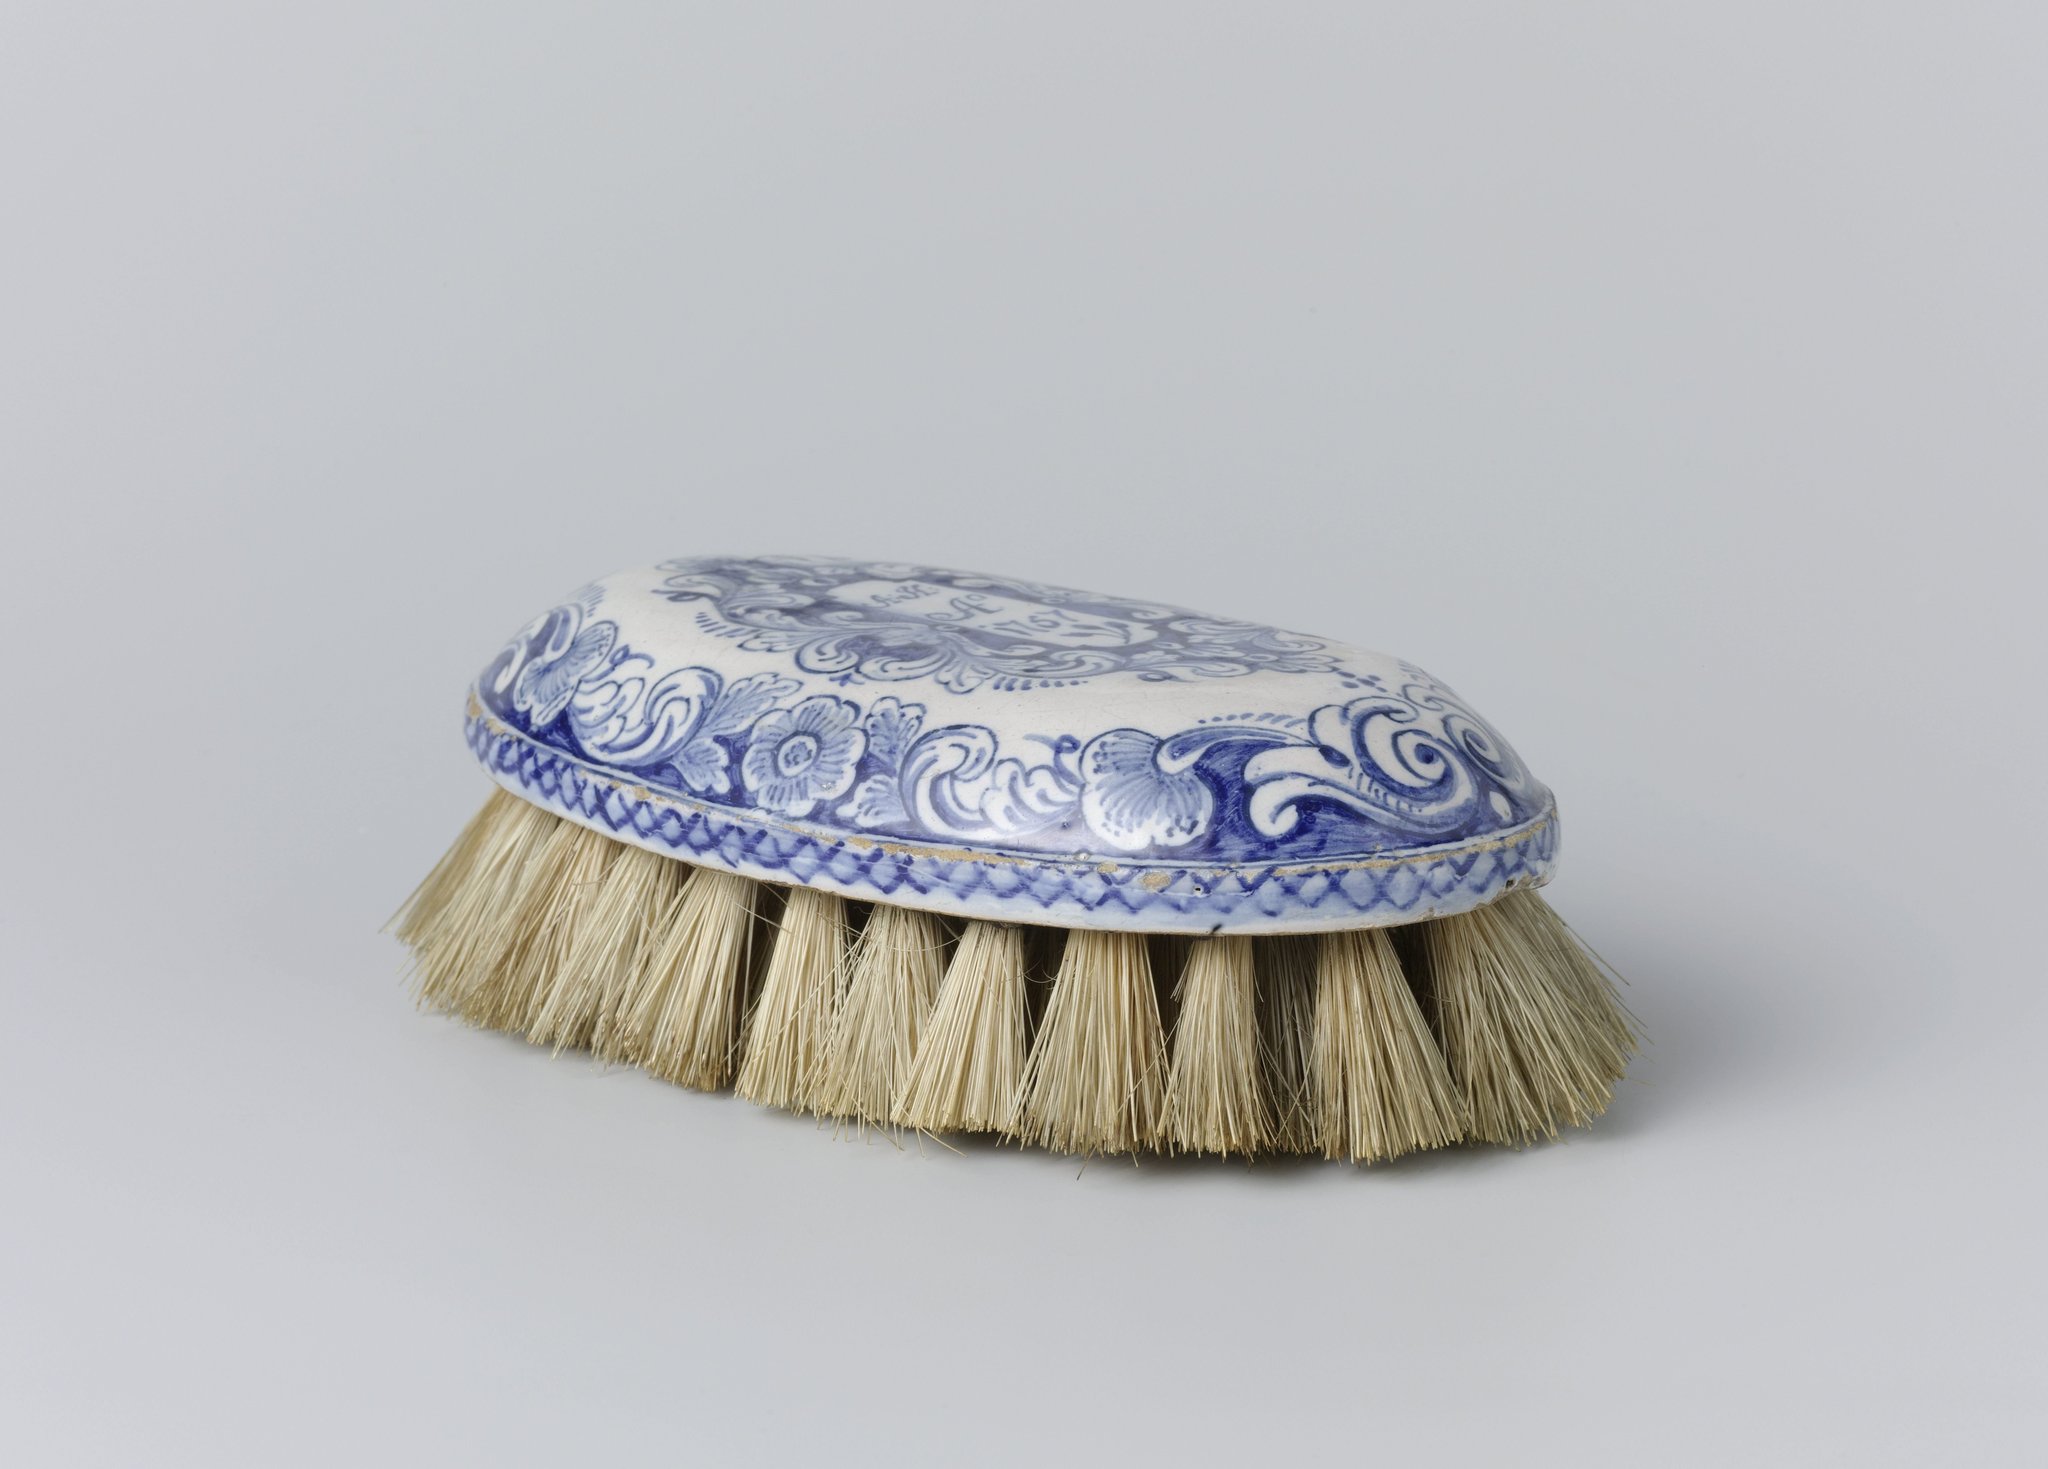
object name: borstelrug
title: Borstelrug, beschilderd met ranken en bloemmotieven, de initialen AH en het jaartal 1757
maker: gatse sytses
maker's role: plateelschilder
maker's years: 1799-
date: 1757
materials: faience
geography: makkum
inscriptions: date: ‘Ao 1757’, monogram: ‘A:H’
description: Borstelrug van faience, beschilderd in blauw met ranken en bloemmotieven, de initialen AH en het jaartal 1757.